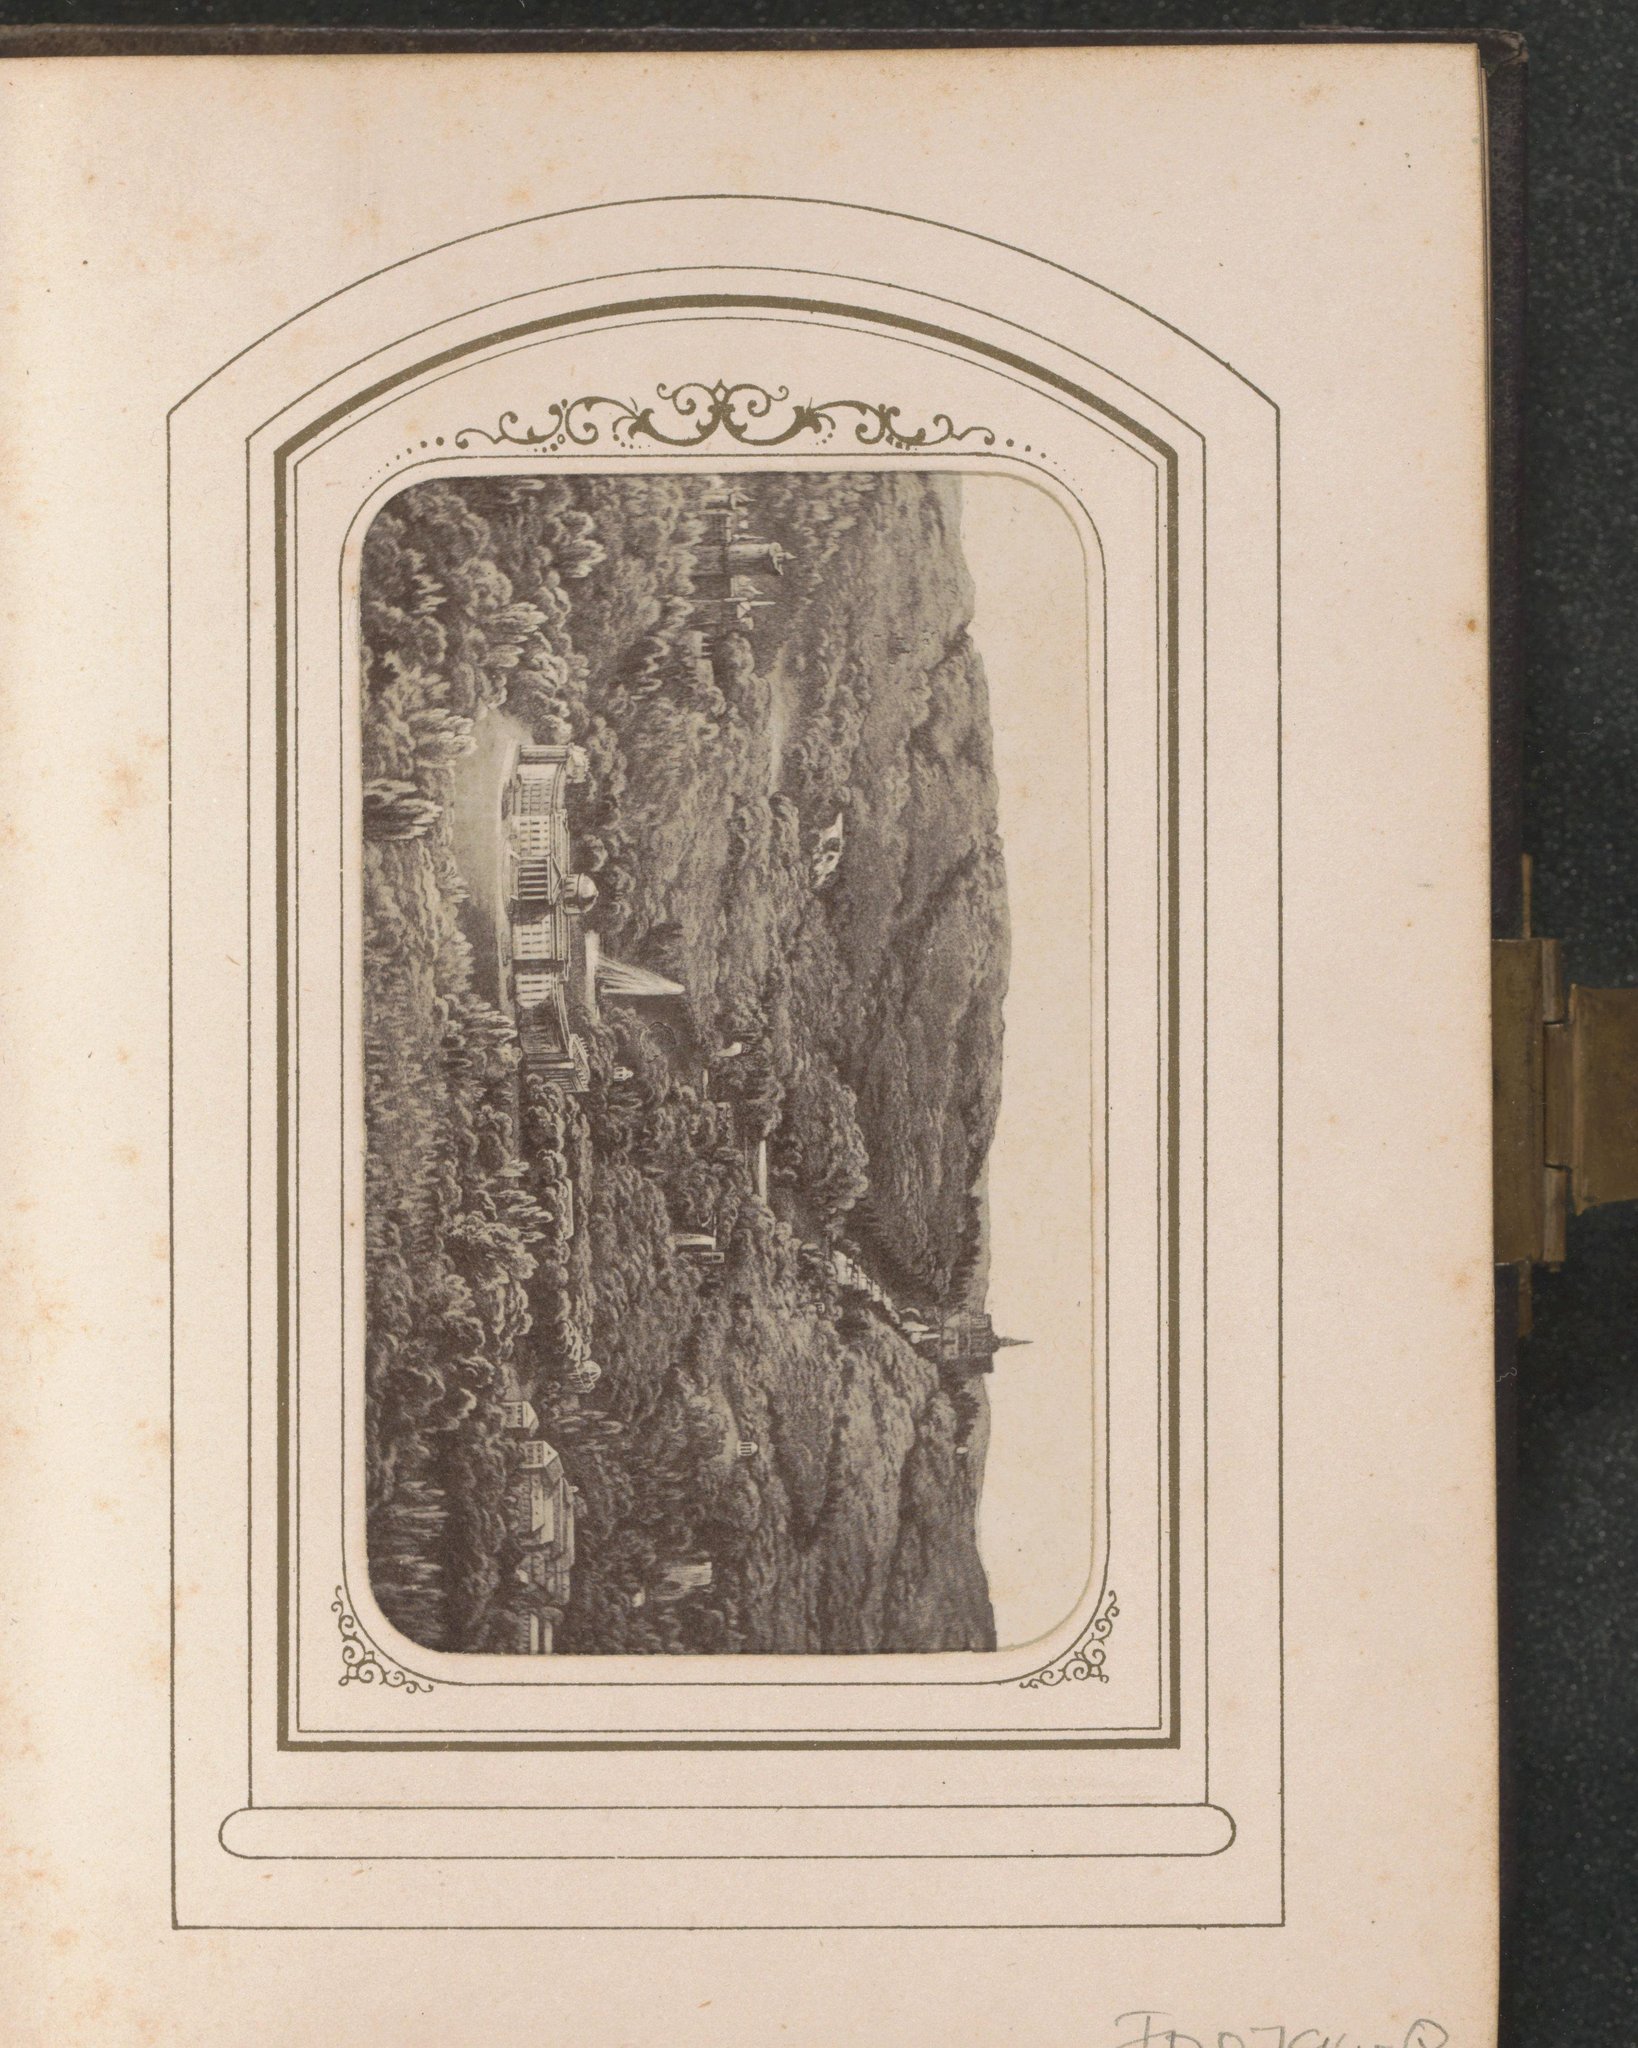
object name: photograph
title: Fotoreproductie van een prent van de Wilhelmshöhe en omgeving bij Kassel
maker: Anonymous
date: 1860-1890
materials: cardboard, paper, photographic support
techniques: albumen print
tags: travelling; tourism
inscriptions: number: ‘Nro. 347.’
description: Onderdeel van Fotoalbum met 36 opnames van Europese landen.